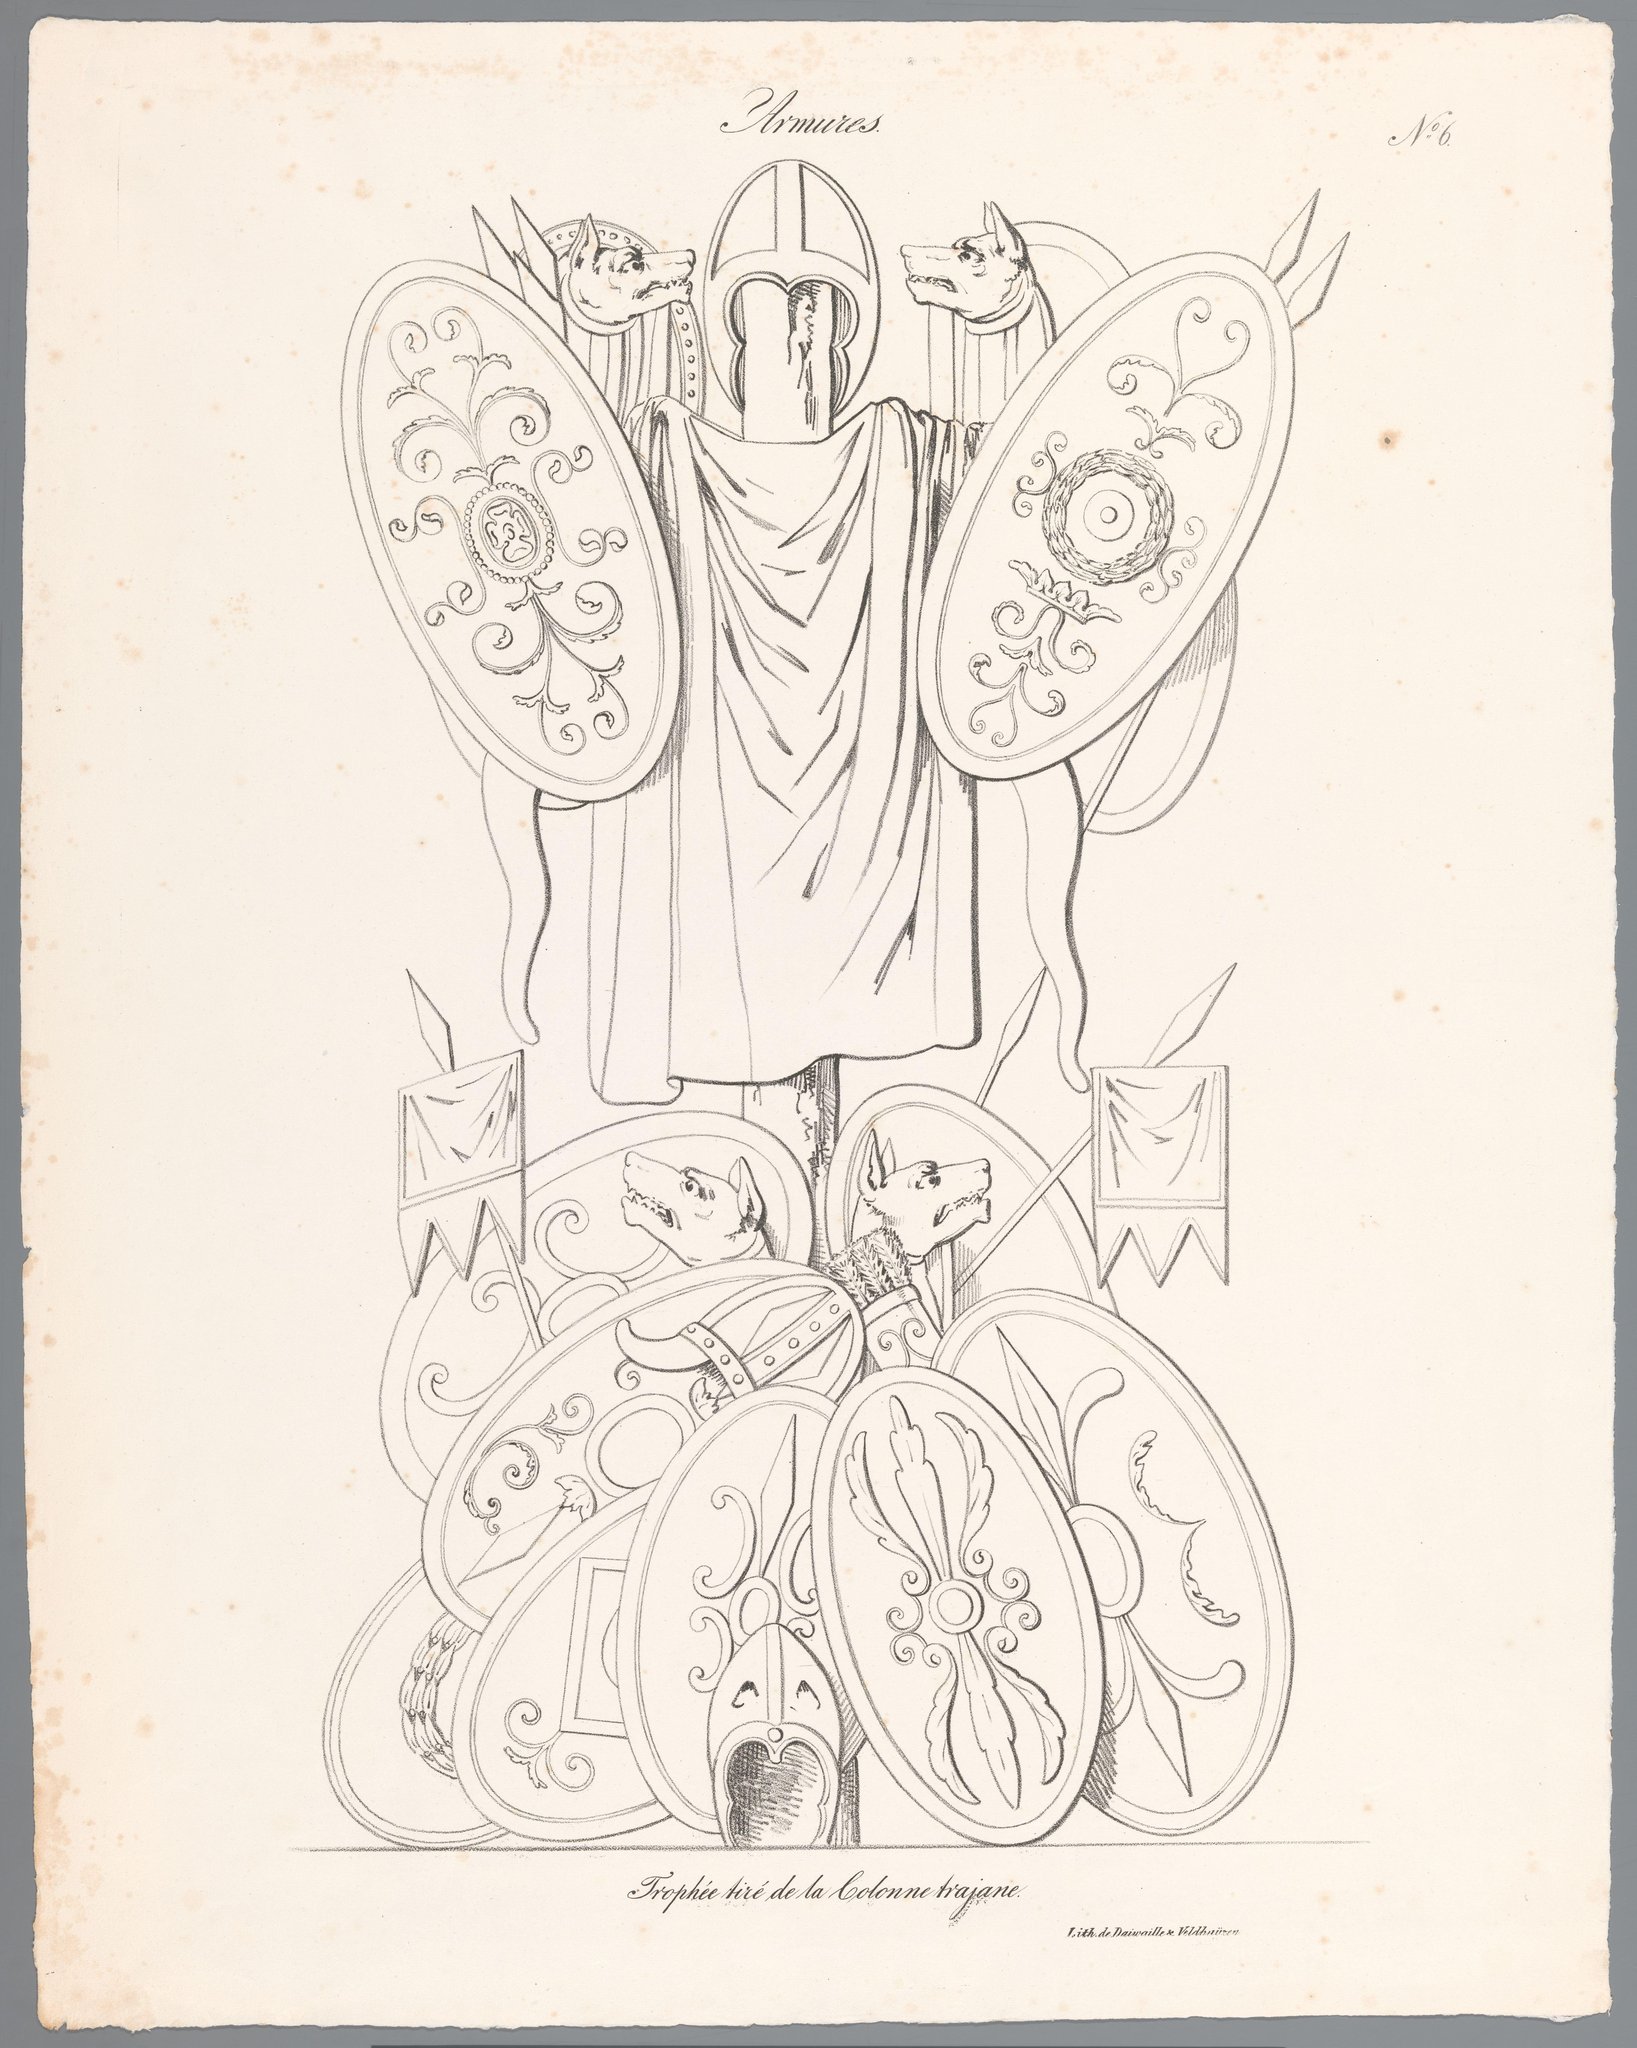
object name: print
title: Cours de dessin-ornemens à L'usage des Eleves qui se destinent à l'étude des Beaux-Arts et à la pratique des Arts mécaniques. Formé de tous les meilleurs genres de modèles, antiques et modernes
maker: jean augustin daiwaille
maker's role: draughtsman, print maker, printer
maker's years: 1786-1850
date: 1820-1833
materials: paper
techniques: lithograph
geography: amsterdam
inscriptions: collector's mark: Lugt 2228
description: De trofee bestaat hoofdzakelijk uit schilden, helmen en speren. Genummerd rechtsboven: No. 6. Deze prent maakt deel uit van een omslag met een titelblad en zes prenten.